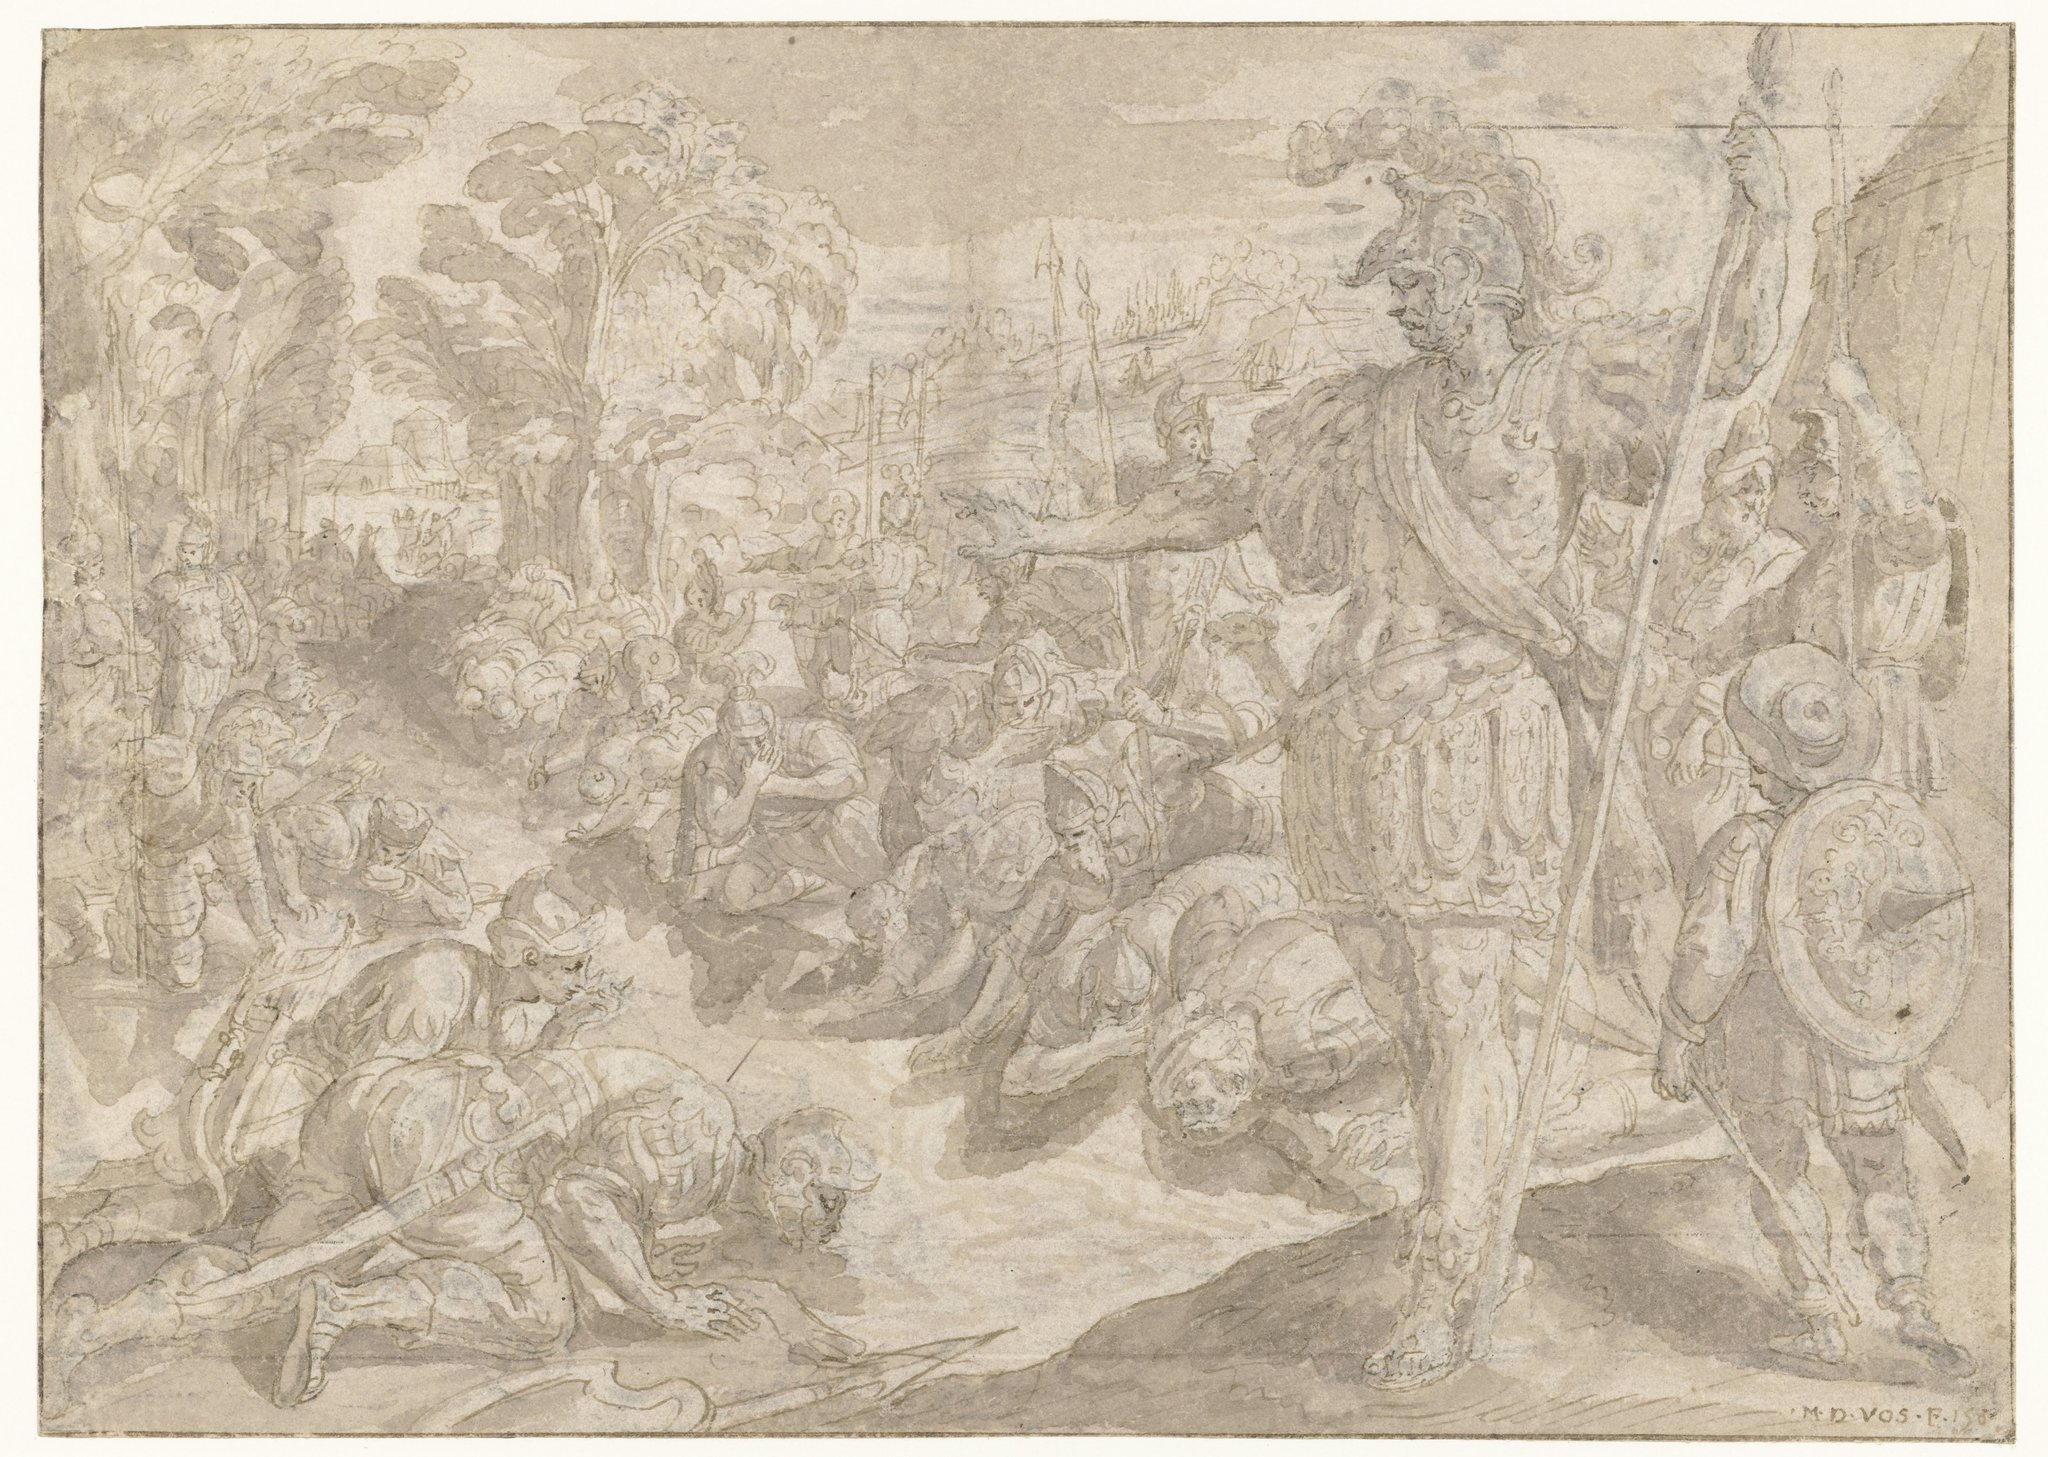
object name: drawing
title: Gideon beveelt zijn manschappen te drinken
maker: maerten de vos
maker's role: draughtsman, painter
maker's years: 1532-1603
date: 1580-1585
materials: ink, paint, paper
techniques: brush, pen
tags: those who lap water by putting their hand to their mouth are separated from those who kneel down to drink the water ~ selection of gideon's men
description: Gehoorzamend aan Gods gebod beveelt Gideon zijn manschappen te drinken zodat hij onder hen kan kiezen. Ontwerp voor een prent.